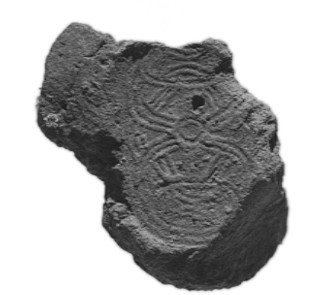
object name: sealing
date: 2030-1640 BCE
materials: clay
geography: egypt